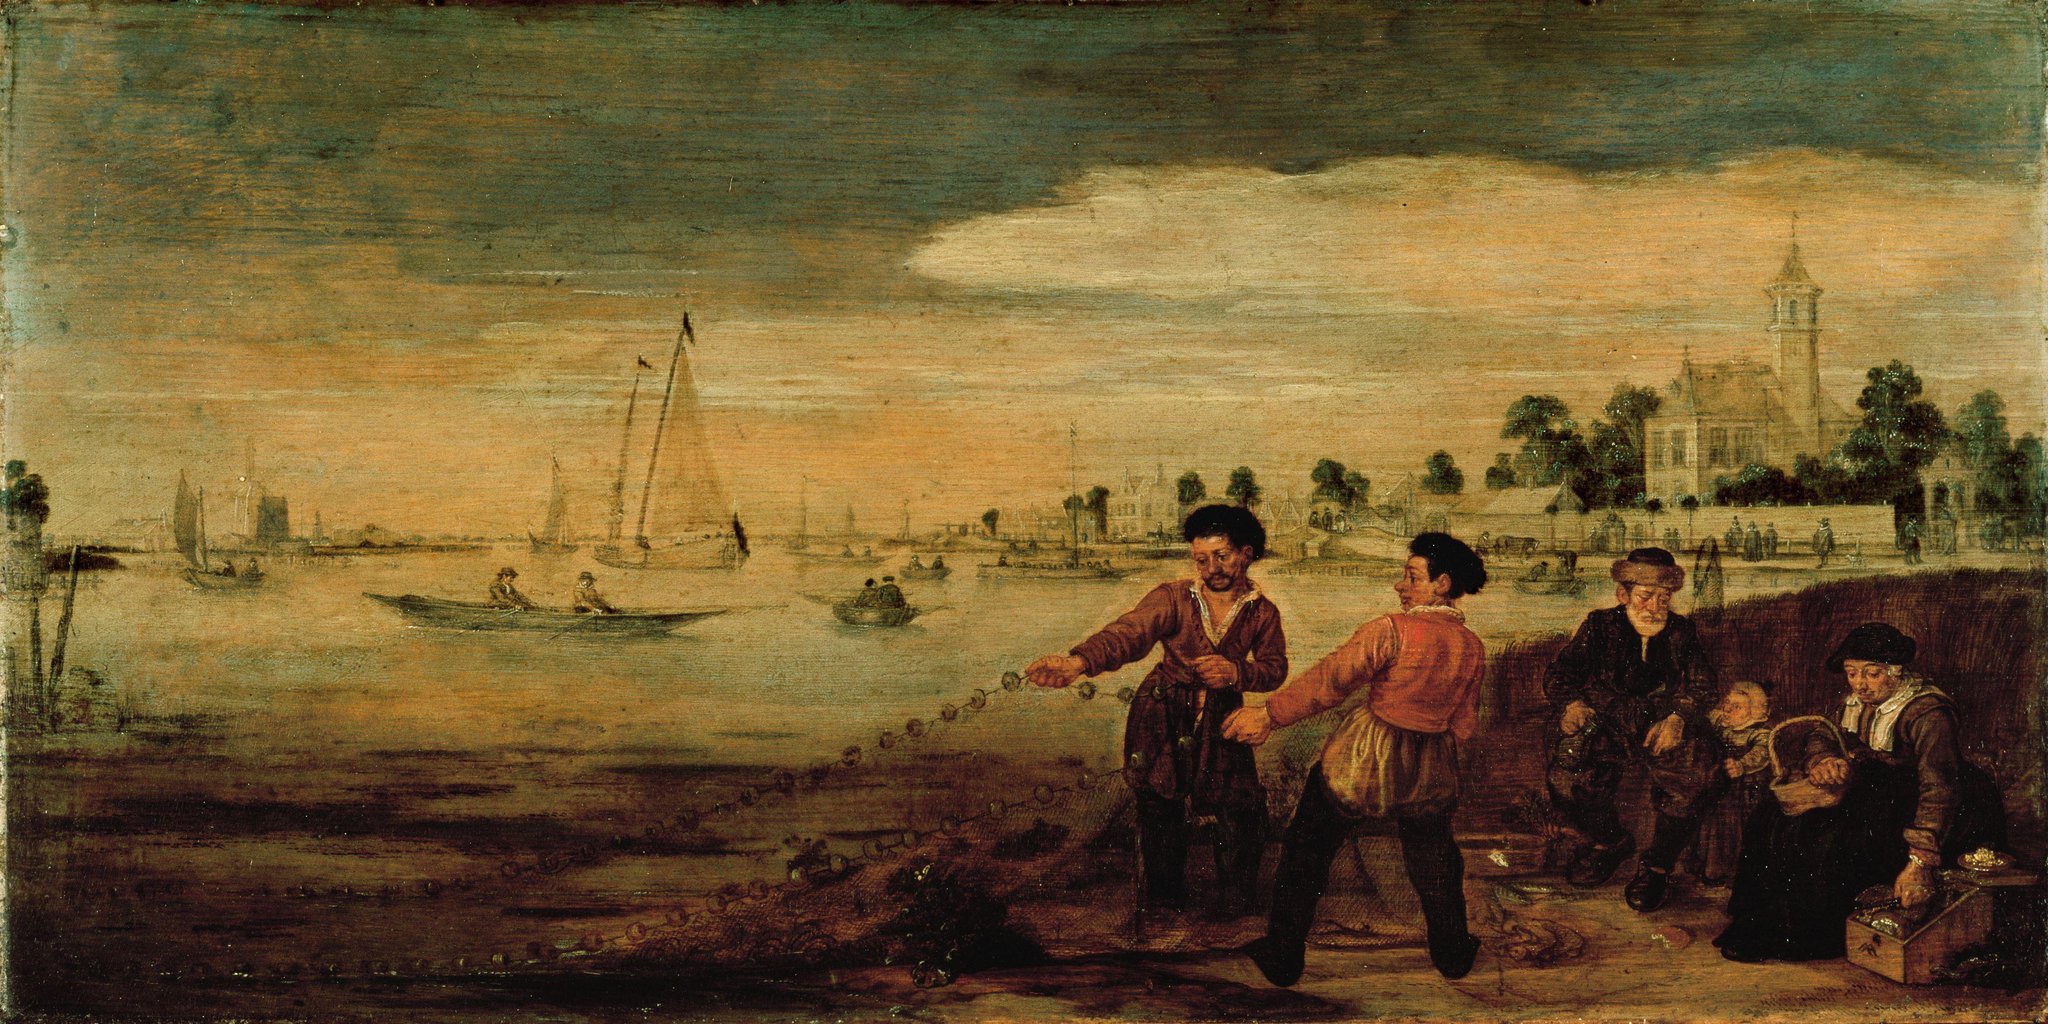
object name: painting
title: Fishermen on the Bank of the Amstel near the Pauwentuin, Amsterdam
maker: arent arentsz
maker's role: draughtsman, painter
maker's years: 1585-1631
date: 1625-1630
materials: oil, panel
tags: fishing net, fresh-water fishery, river (+ landscape with figures, staffage), amsterdam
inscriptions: signature, in ligated monogram, at bottom right on the chest: ‘AA’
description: Vissers aan de Amstel te Amsterdam in de nabijheid van 'De Pauwentuin', het buitenhuis van der familie Pauw. Twee mannen halen een net binnen.